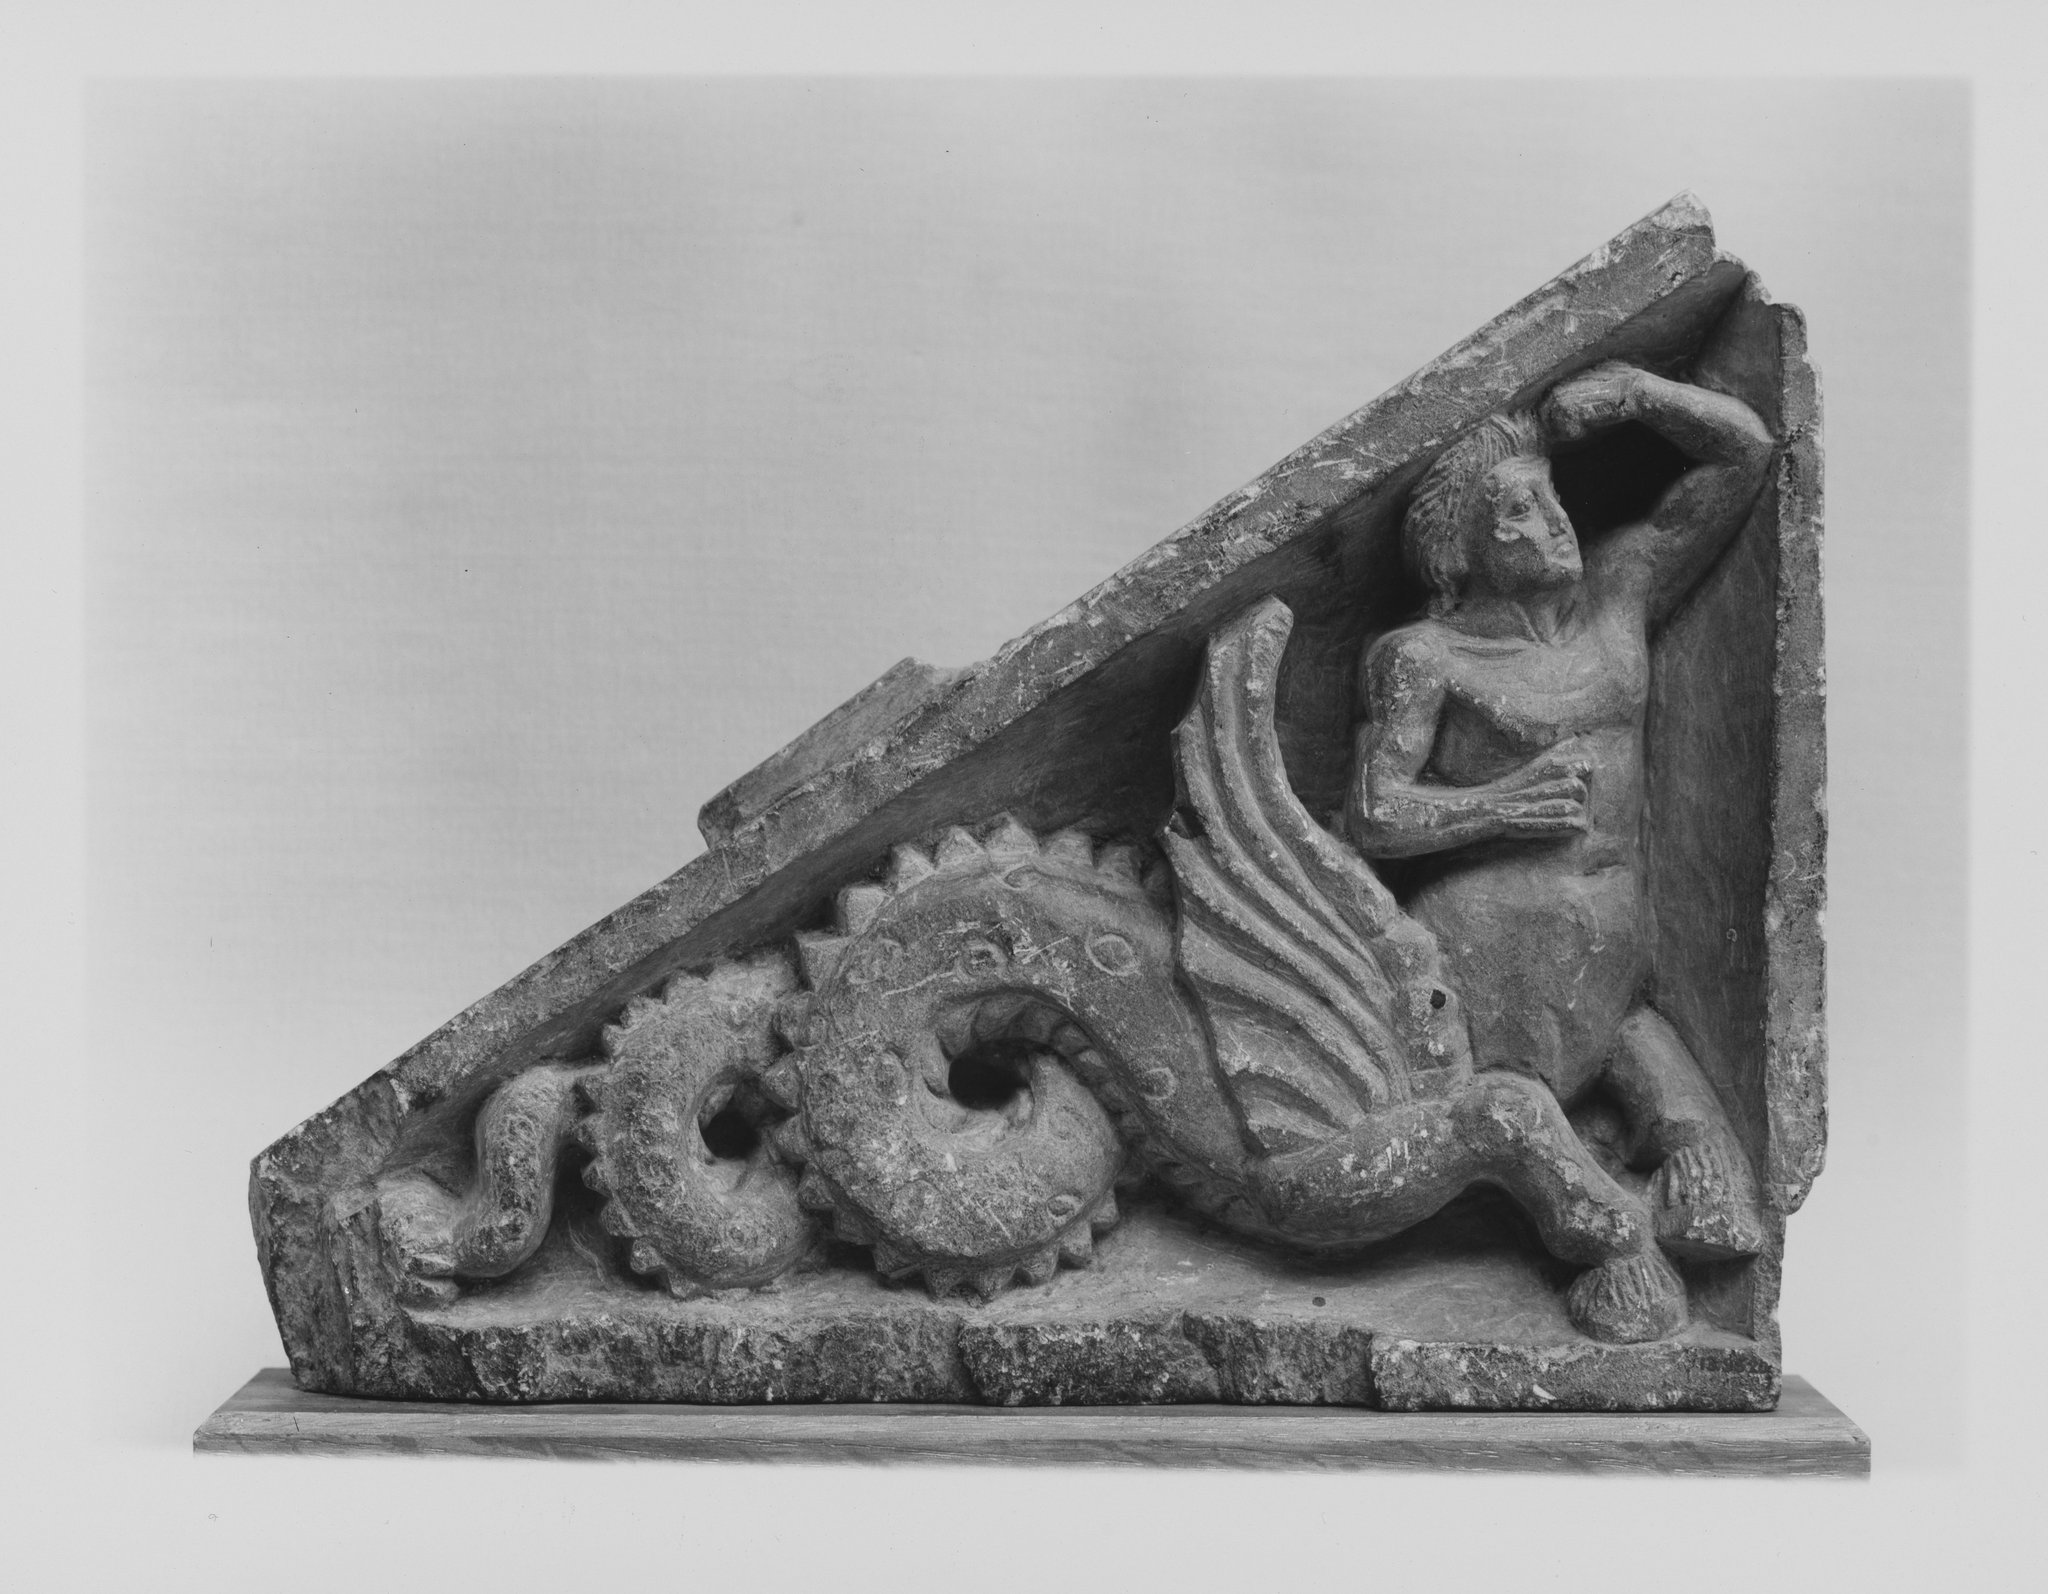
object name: panel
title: Panel with Marine Deity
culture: gandhara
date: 1-100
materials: stone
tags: gandhara